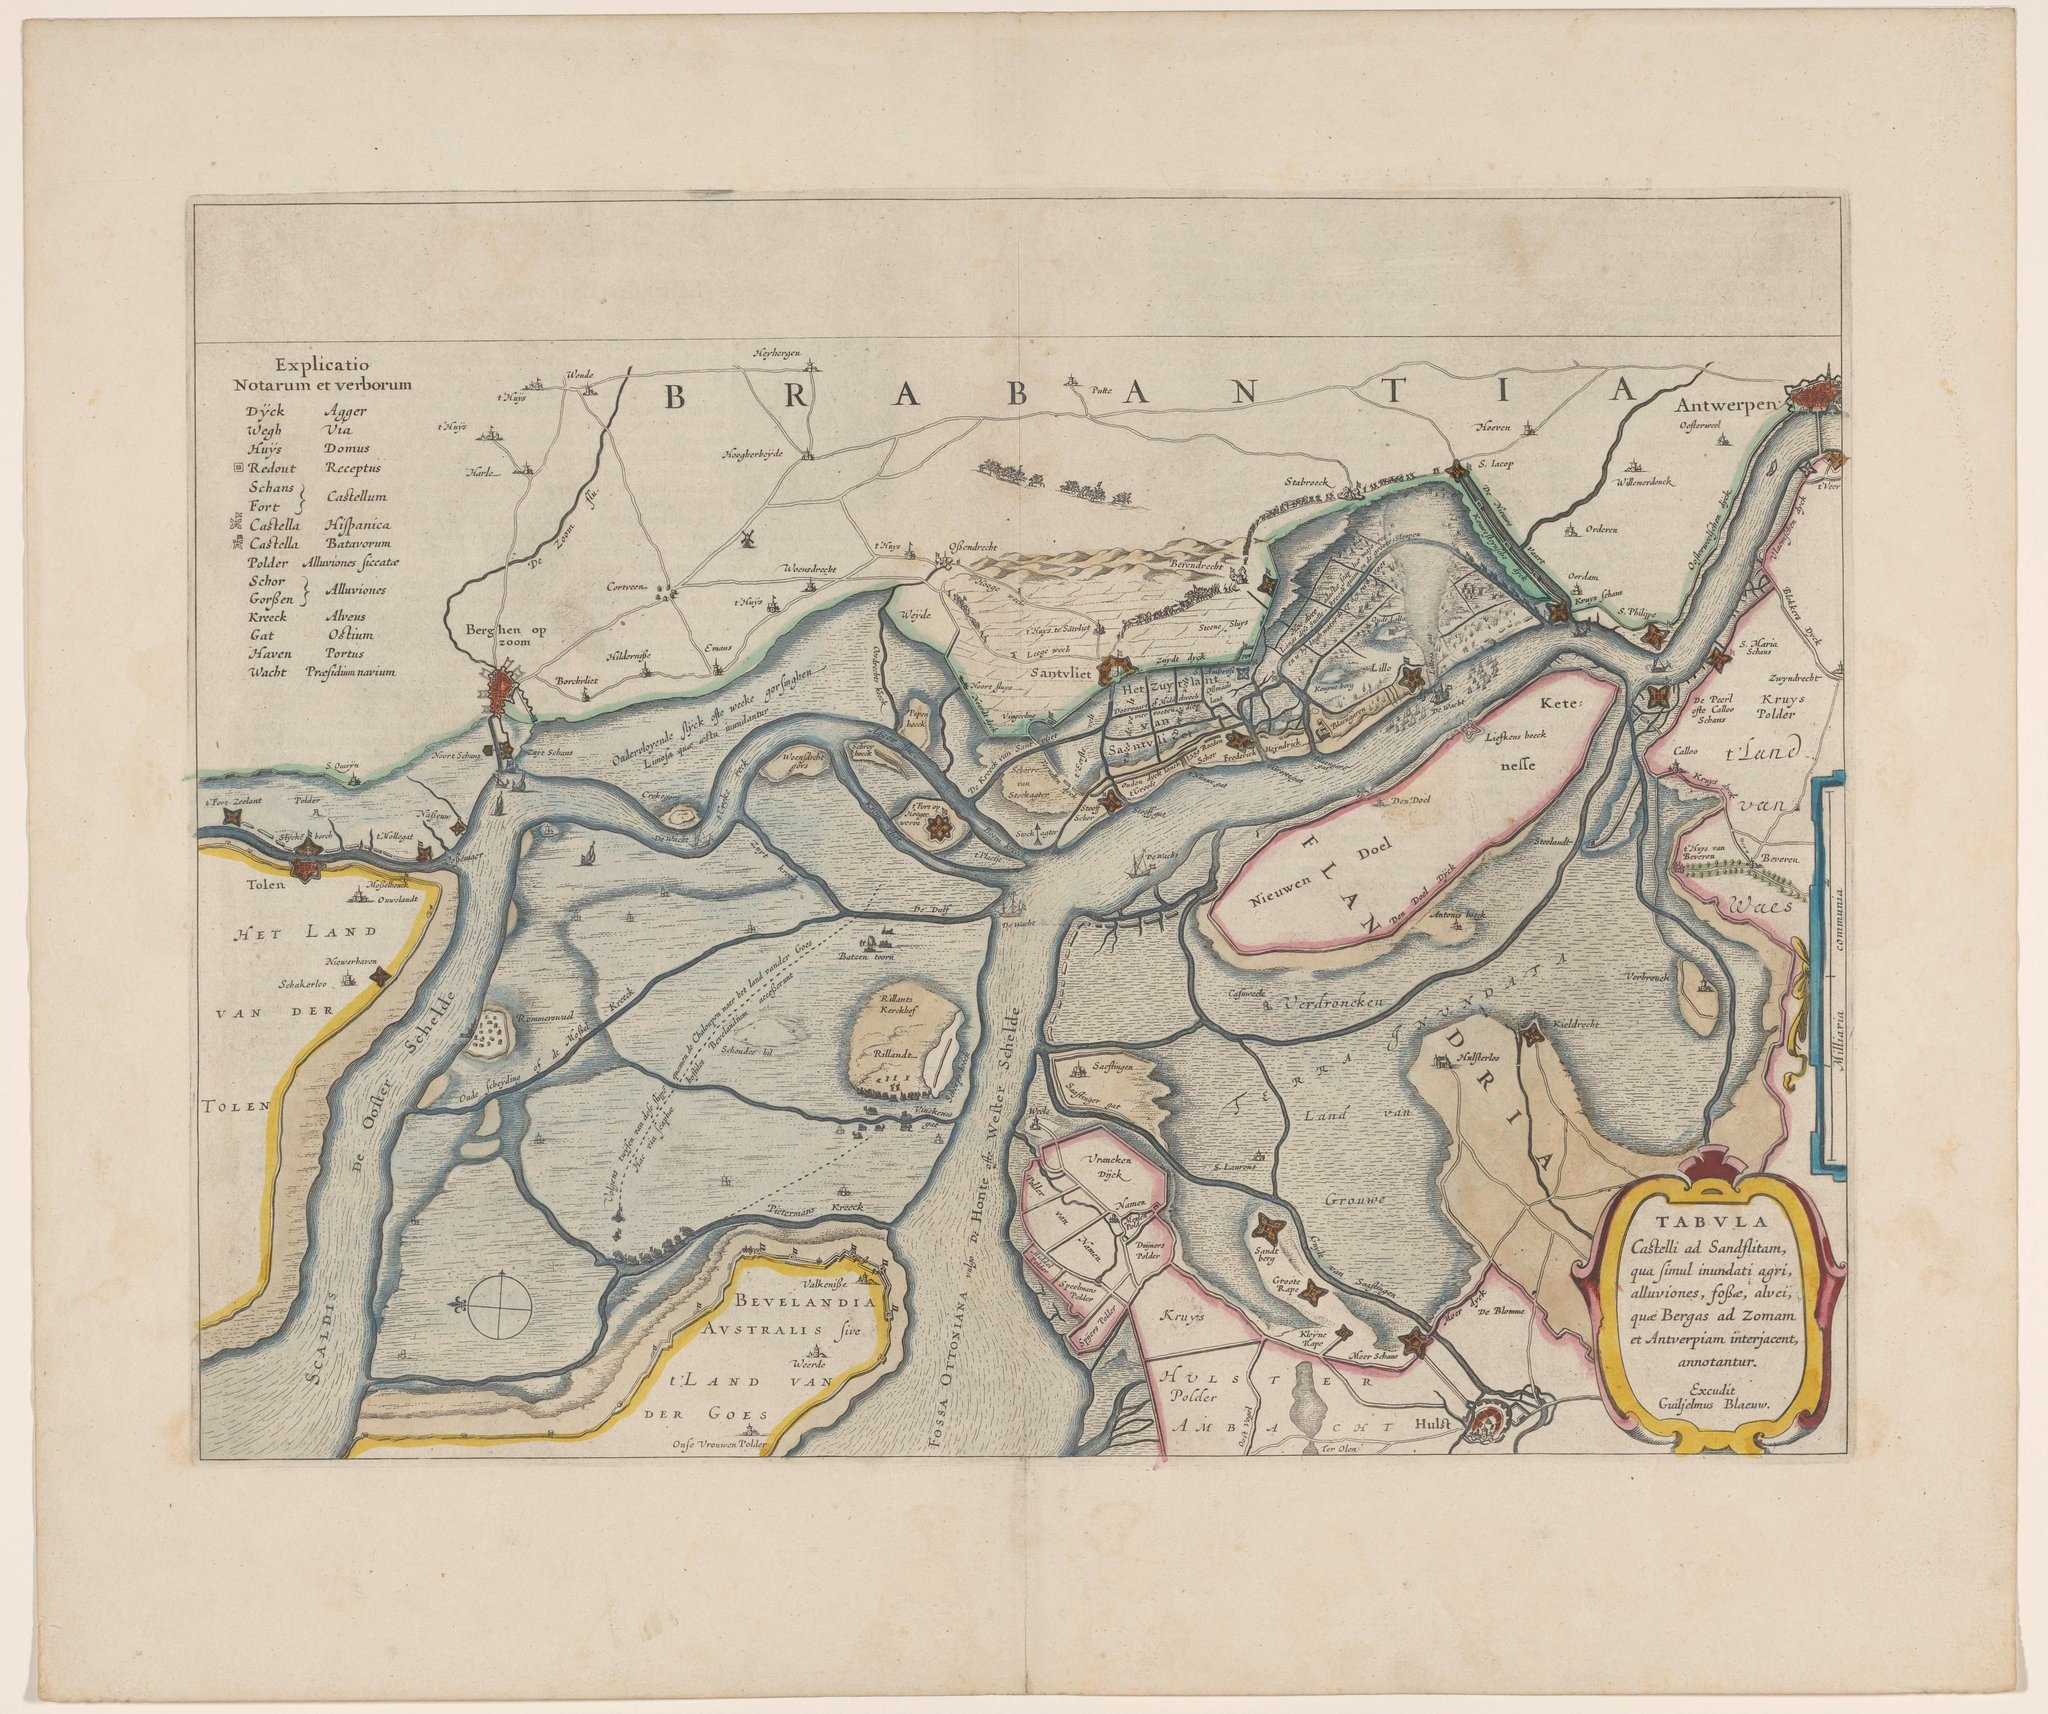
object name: print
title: Forten aan de Ooster- en Westerschelde, 1627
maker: Anonymous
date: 1635-1661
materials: paper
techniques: engraving, etching, hand coloring, letterpress printing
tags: frederick henry (prince of orange), maps of separate countries or regions, antwerp, bergen op zoom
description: Prent gebruikt in: Blaeu, Willem Janszoon en Johannes Willemszoon Blaeu. Toonneel des aerdriicx, ofte nieuwe Atlas, dat is de beschryving van alle landen. 2 delen. Amsterdam: Willem Jansz. en Johannes Willemszoon Blaeu, 1635, dl. 1. Of in: Blaeu, Willem Janszoon en Cornelis Blaeu. Toonneel des aerdriicx, ofte nieuwe Atlas, dat is de beschryving van alle landen. 3 delen. Amsterdam: Johannes Willemszoon Blaeu, 1642-1643, dl. 1 (1642). Of in: Blaeu, Willem Janszoon en Johannes Willemszoon Blaeu. Toonneel des aerdrycx, ofte nieuwe Atlas, dat is de beschryving van alle landen. 4 delen. Amsterdam: Johannes Willemszoon Blaeu, 1647-1650, dl. 1 (1647-1648). Of in: Blaeu, Willem Janszoon en Johannes Willemszoon Blaeu. Toonneel des aerdrycx, ofte nieuwe Atlas, dat is de beschryving van alle landen. 4 delen. Amsterdam: Johannes Willemszoon Blaeu, 1649-1650, dl. 1 (1649). Of in: Blaeu, Willem Janszoon en Johannes Willemszoon Blaeu. Toonneel des aerdriicx, ofte niuew Atlas, dat is beschryving van alle landen. 6 delen. Amsterdam: Johannes Willemszoon Blaeu, 1658-1661, dl. 1.